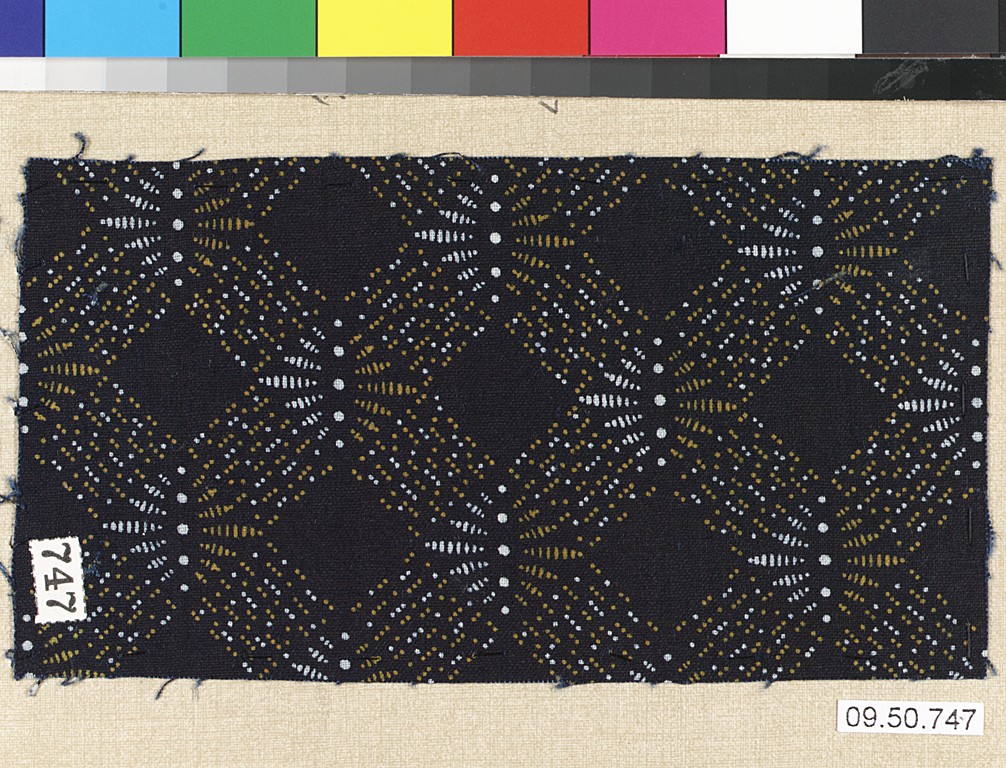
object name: piece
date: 1801-1900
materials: cotton